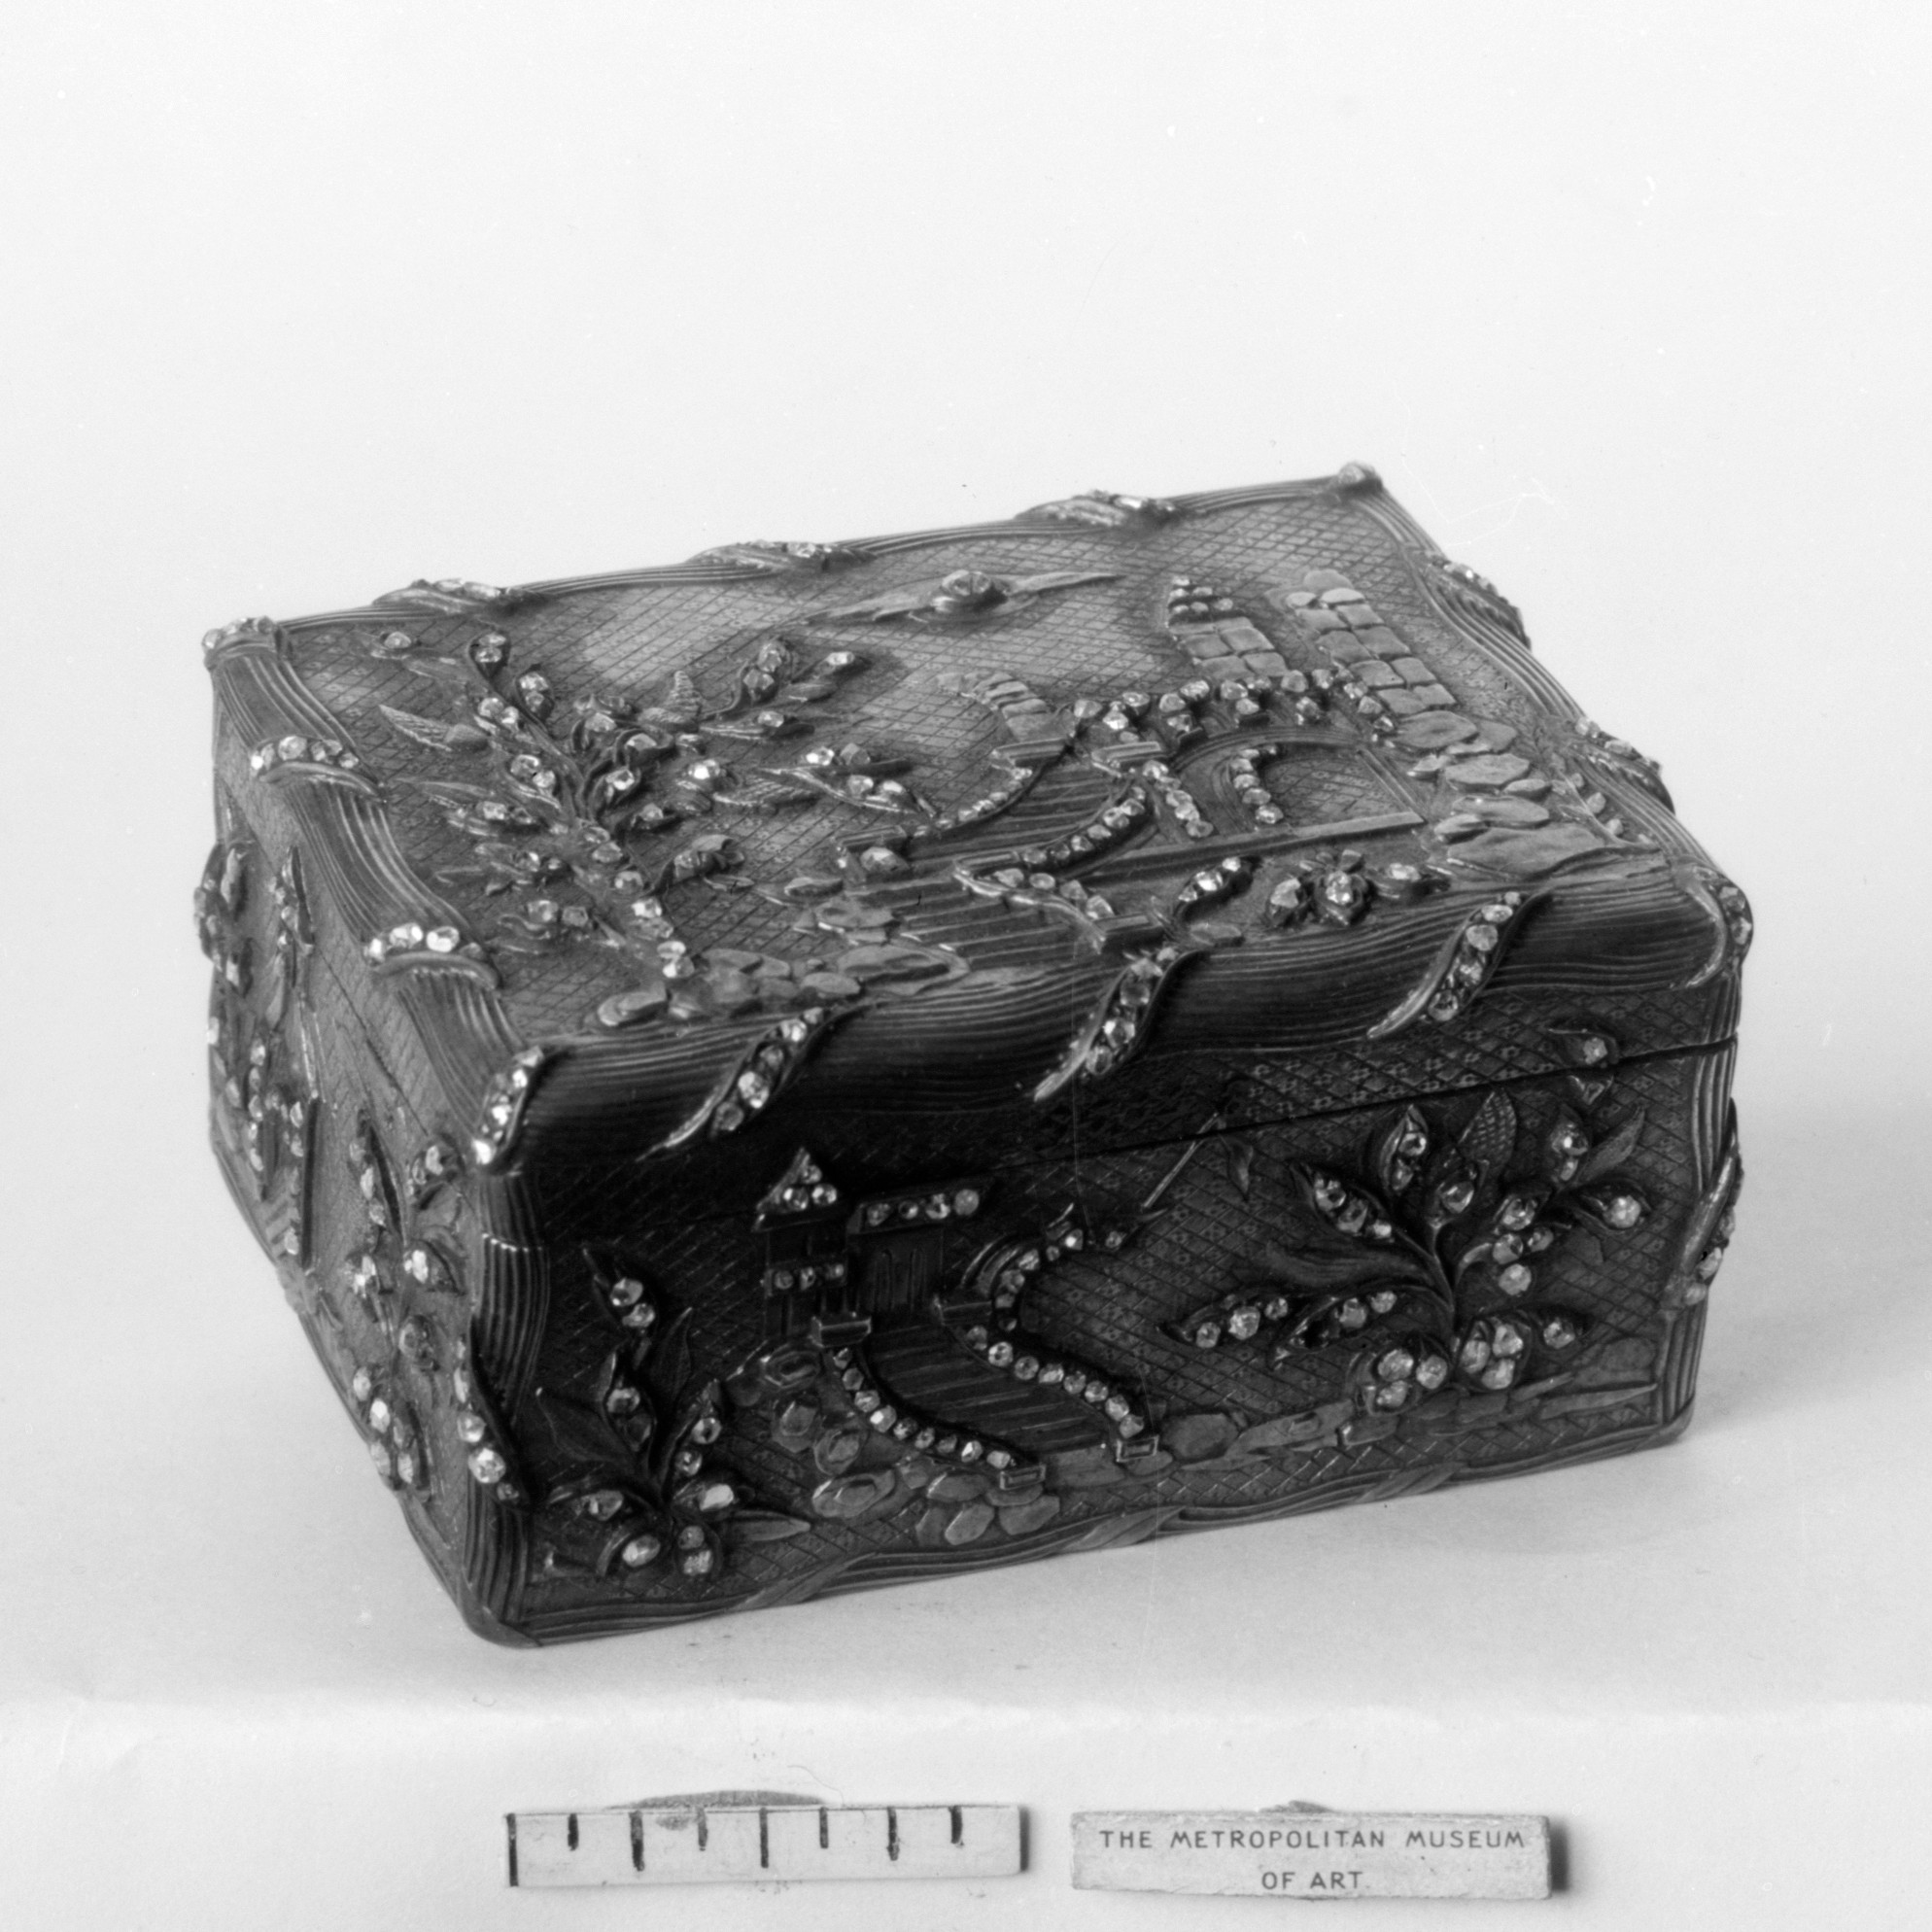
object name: snuffbox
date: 1701-1800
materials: diamond, gold